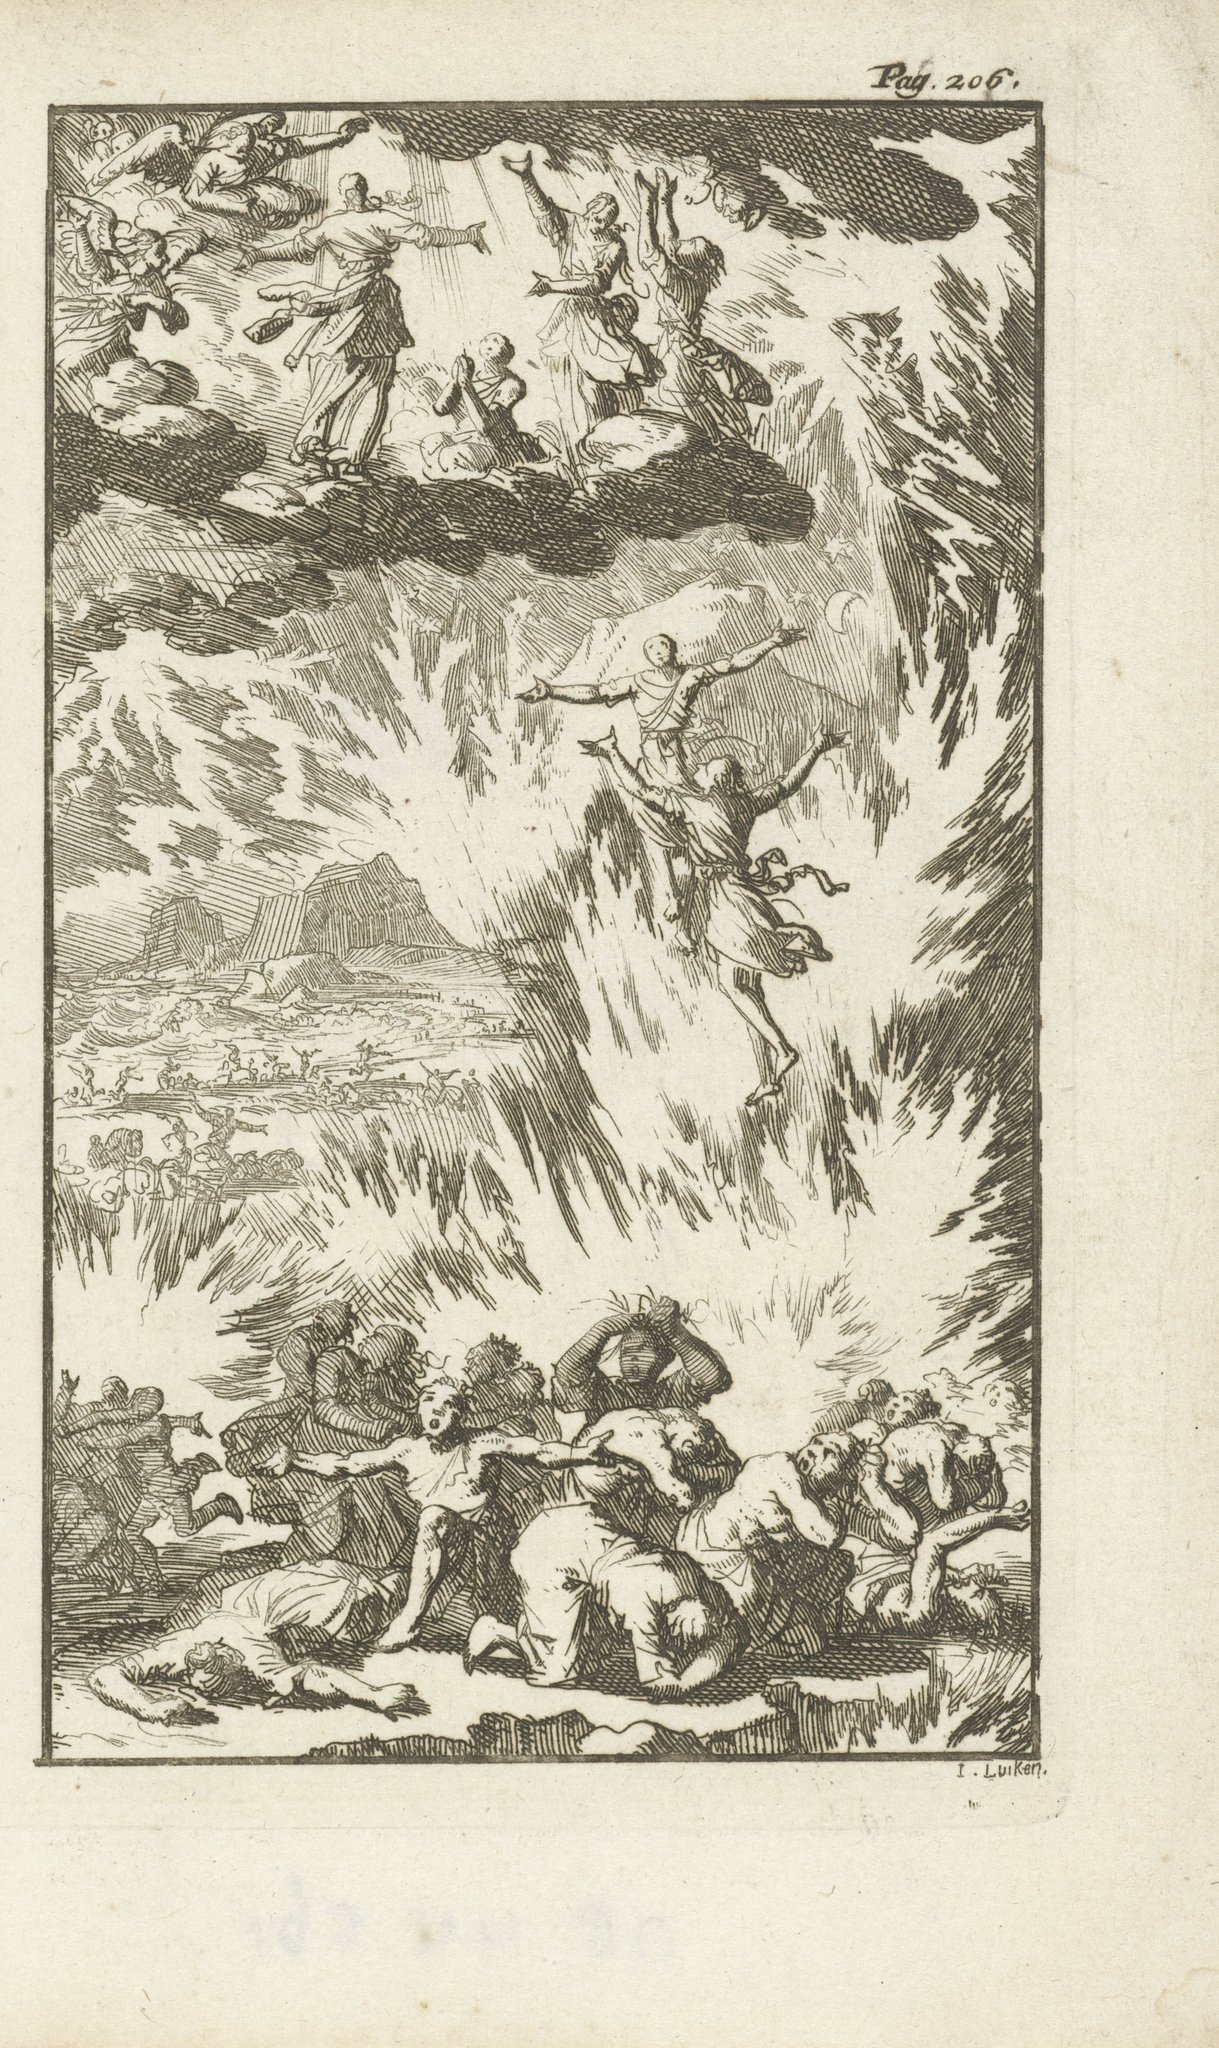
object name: book illustration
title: Verbranding van de aarde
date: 1765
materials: paper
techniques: etching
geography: leiden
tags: the flood and destruction of mankind ~ story of noah (genesis 7:10 - 8:17)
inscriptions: collector's mark: Lugt 2166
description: Illustratie uit: Ray, John. De wereld van haar begin tot haar einde. In drie natuurkundige godgeleerde redeneringen. Leiden: weduwe Abraham Honkoop (I) en Zoon, Cornelis van Hoogeveen junior, 1765.